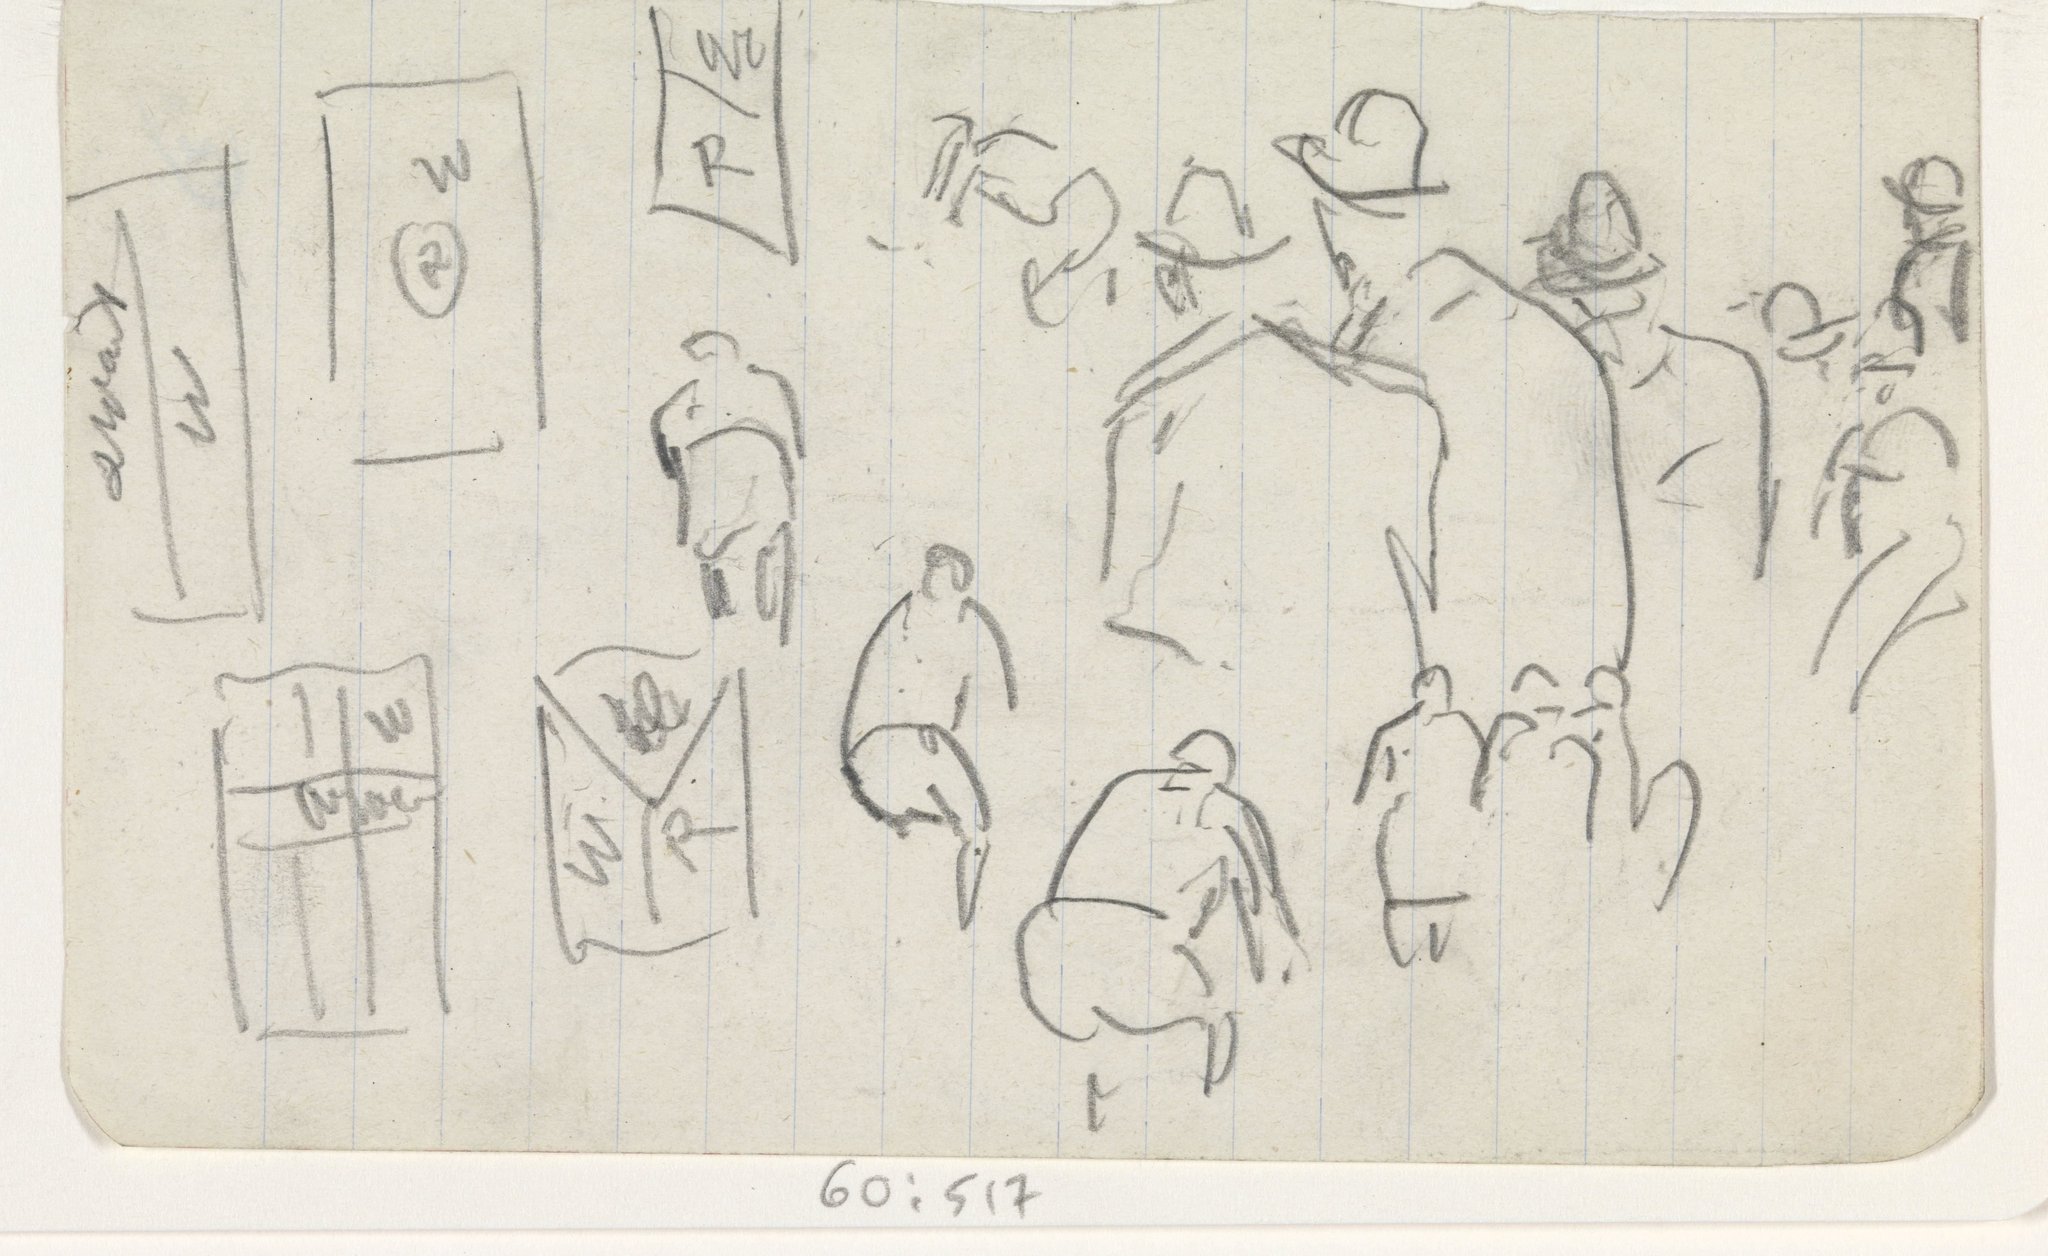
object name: drawing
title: Wielerwedstrijd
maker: leo gestel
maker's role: draughtsman, print maker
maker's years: 1881-1941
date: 1891-1941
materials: pencil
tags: crowd, mob, bicycle racing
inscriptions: collector's mark: Lugt 2228